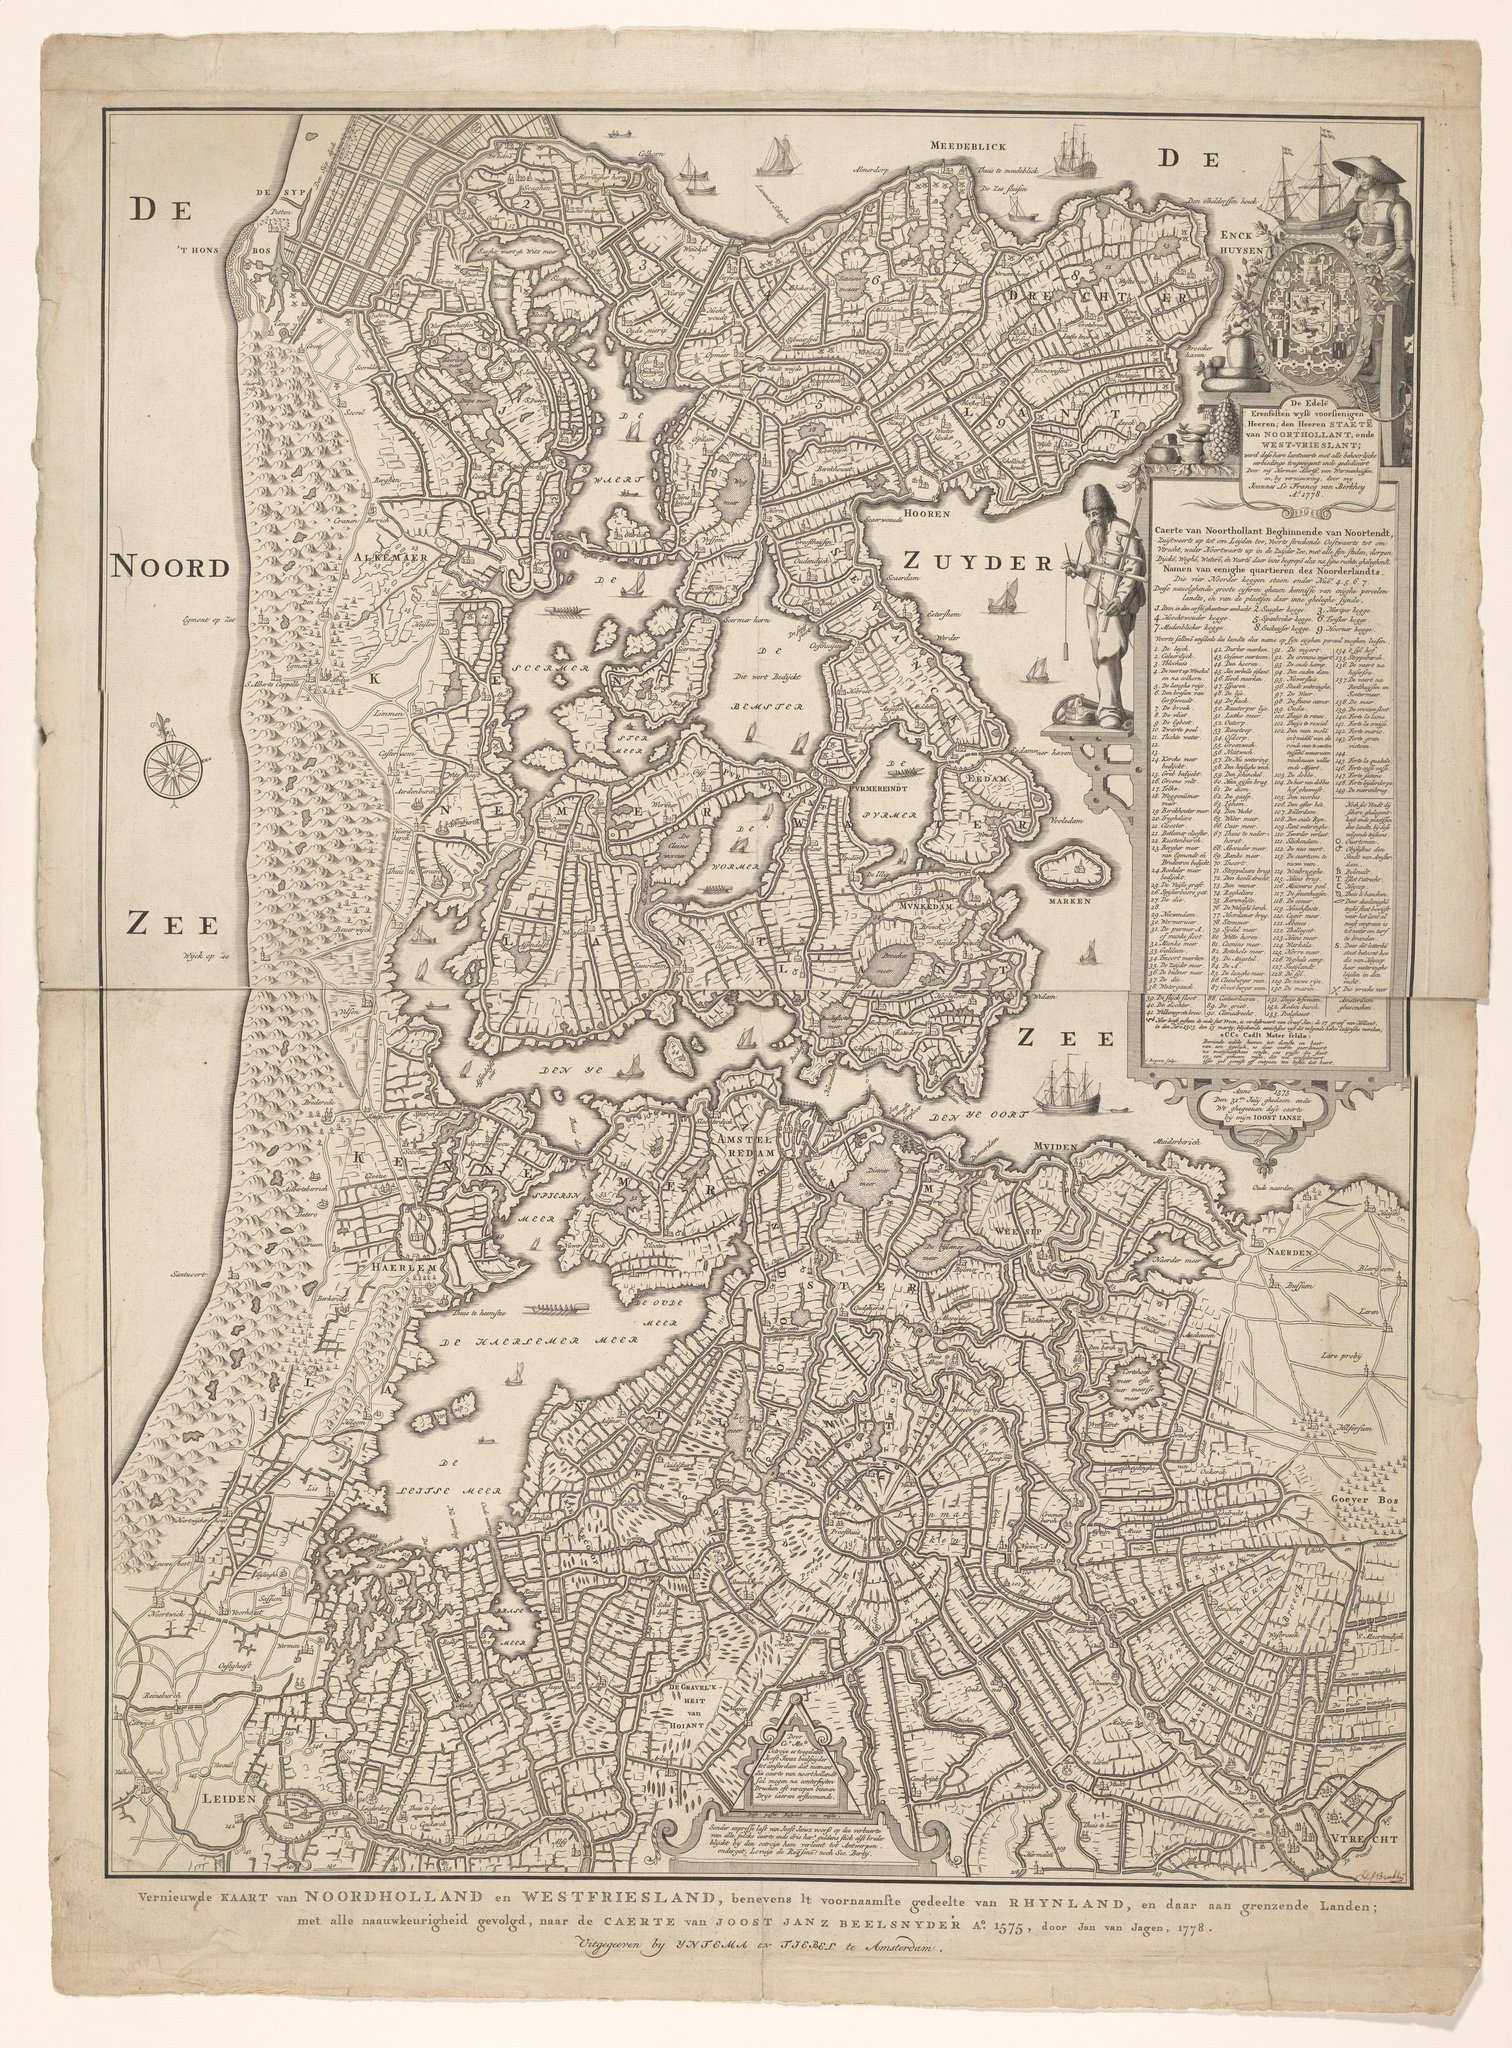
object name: print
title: Kaart van Noord-Holland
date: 1778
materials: paper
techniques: engraving, etching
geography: netherlands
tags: coat of arms (as symbol of the state, etc.), coat of arms (as symbol of the state, etc.) (+ city; municipal), maps of separate countries or regions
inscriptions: collector's mark: Lugt 2233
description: Deze kaart uit 1778 is gemaakt naar een kaart van Noord-Holland uit 1575 (voor de tweede staat uit 1608, zie RP-P-AO-7-2). Langs de onderkant de titel. Rechts een cartouche met de titel van de originele kaart en de legenda in het Nederlands. Links hiervan een staande visser met passer en schietlood. Boven de cartouche de opdracht en een staande boerin bij het provinciewapen, met een scheepsmodel, kazen, groenten en producten van het land. Onderaan in het midden een cartouche met de octrooiverlening van de eerste staat van de originele kaart. De passer hierop dient tevens als schaalstok: Dese passer bespant een mijle.